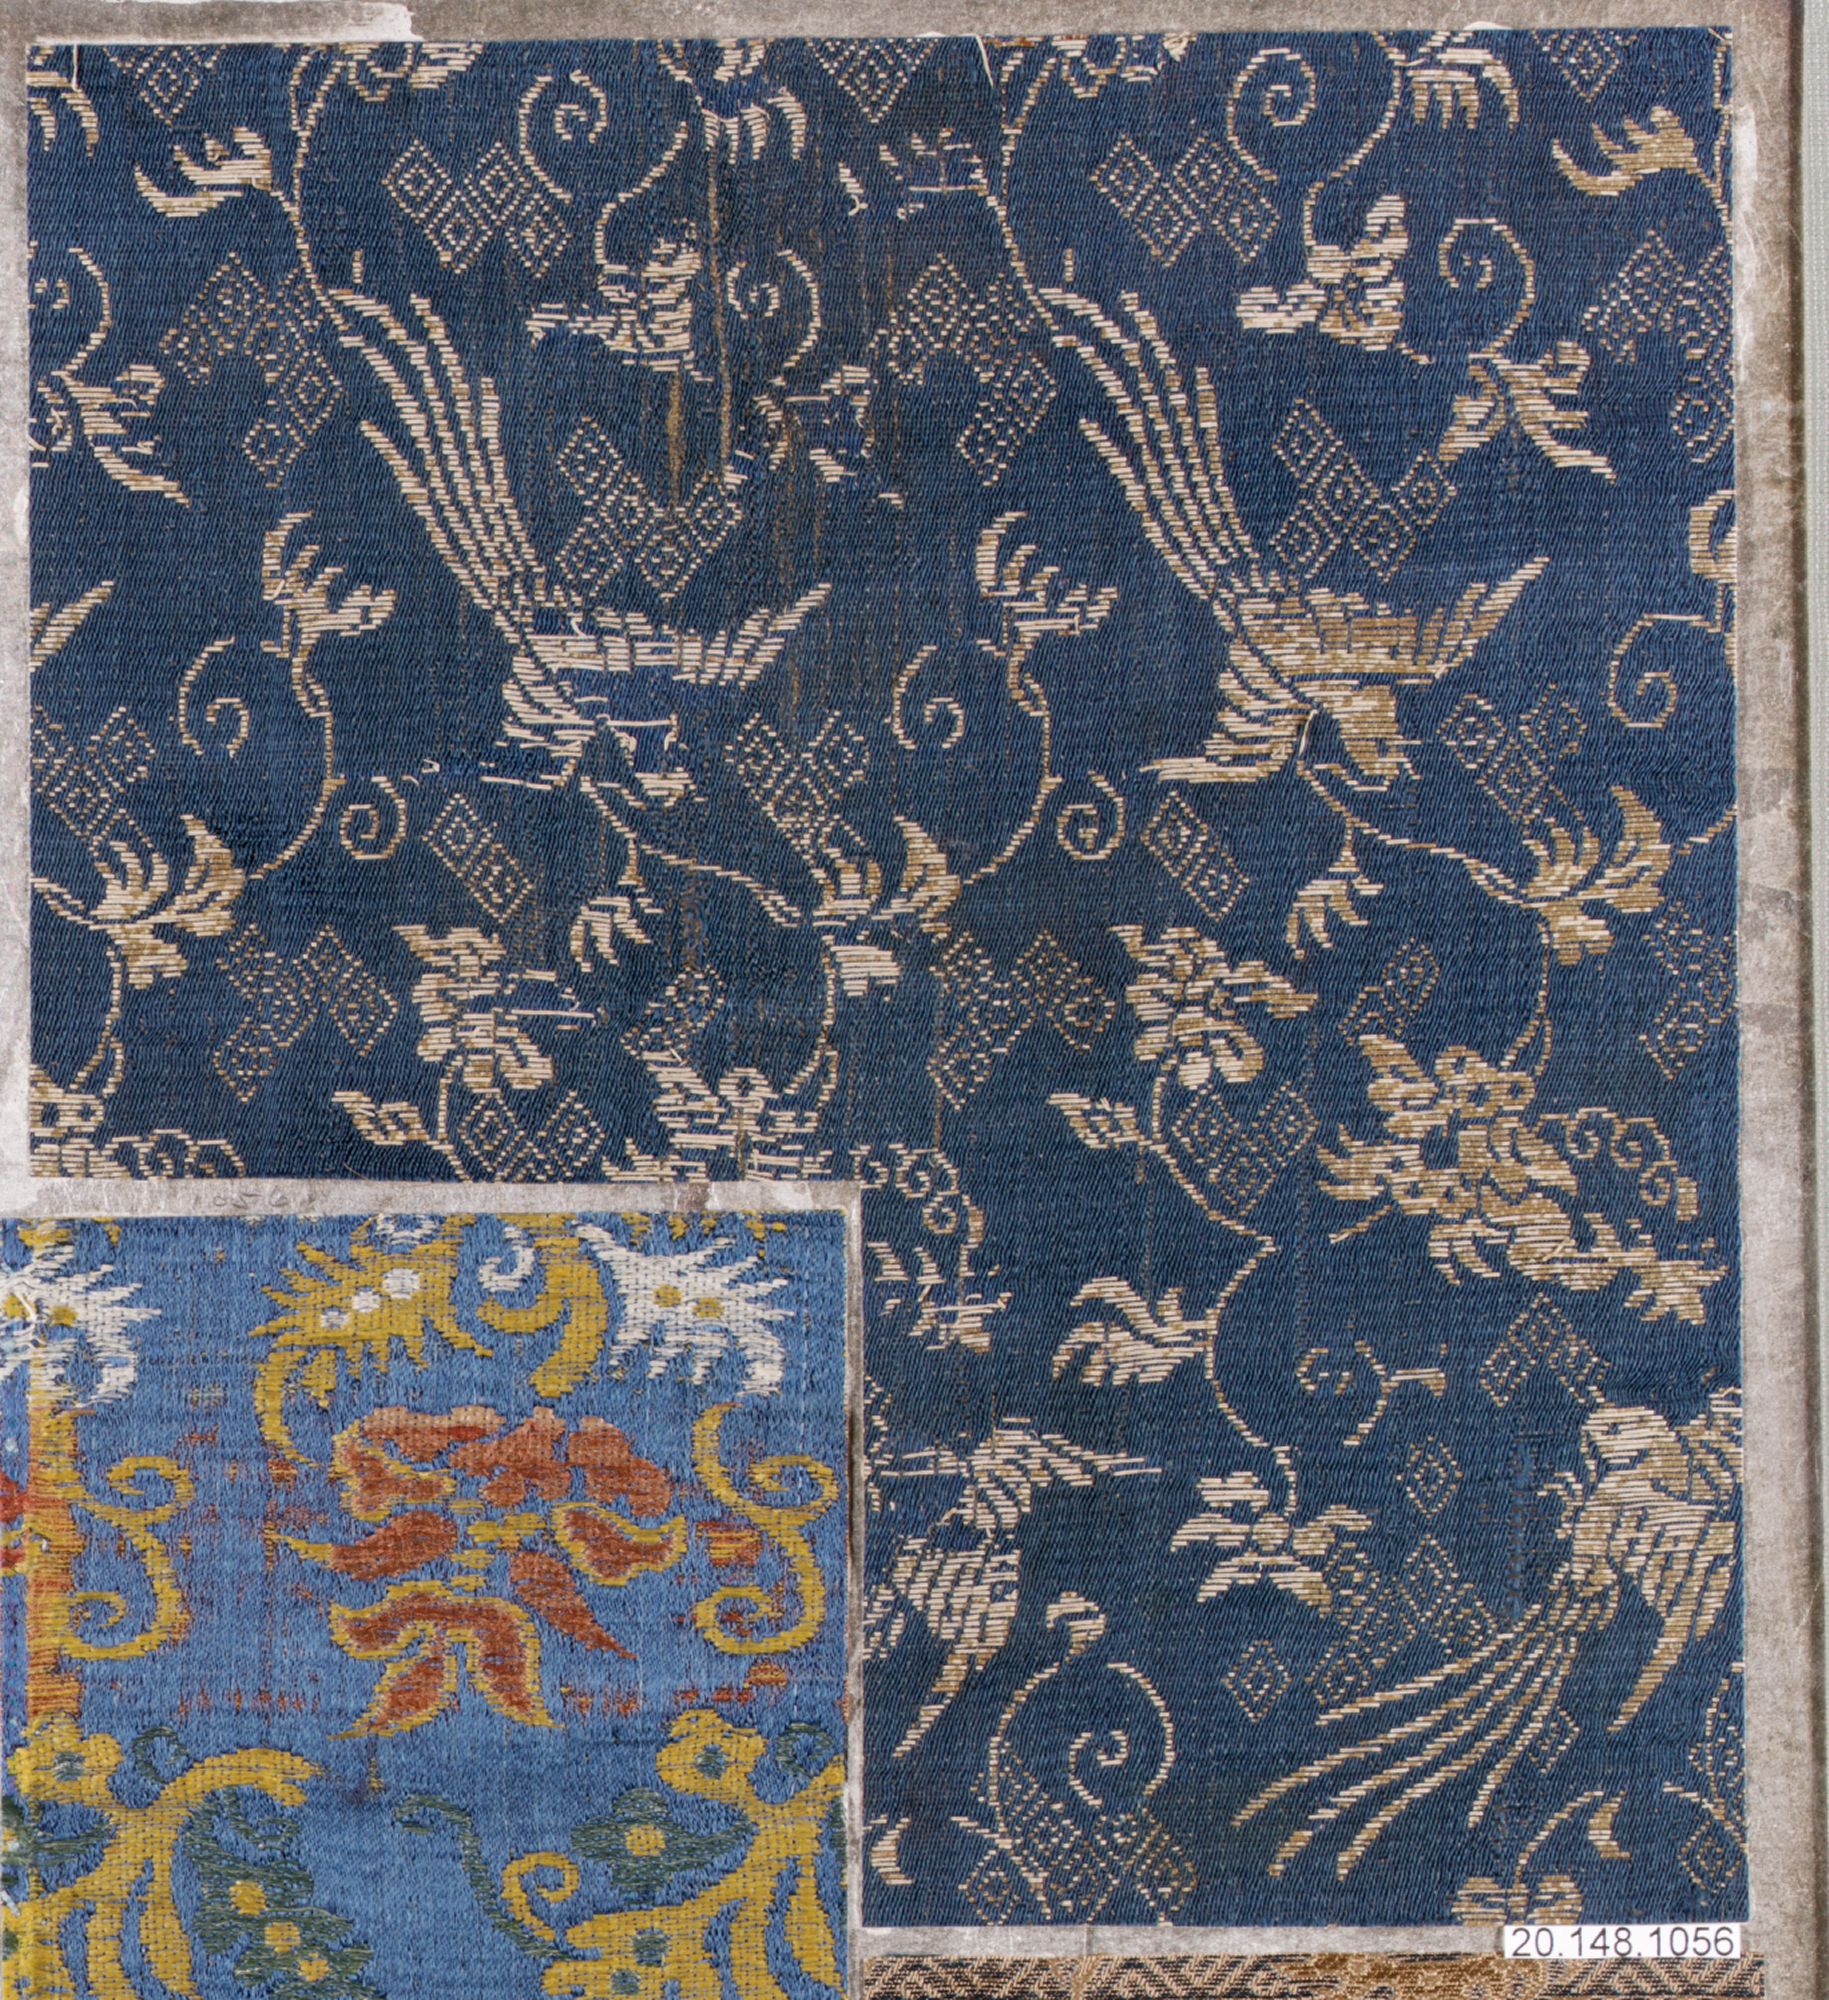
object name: piece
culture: japanese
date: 1701-1800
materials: silk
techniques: compound weave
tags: birds,leaves